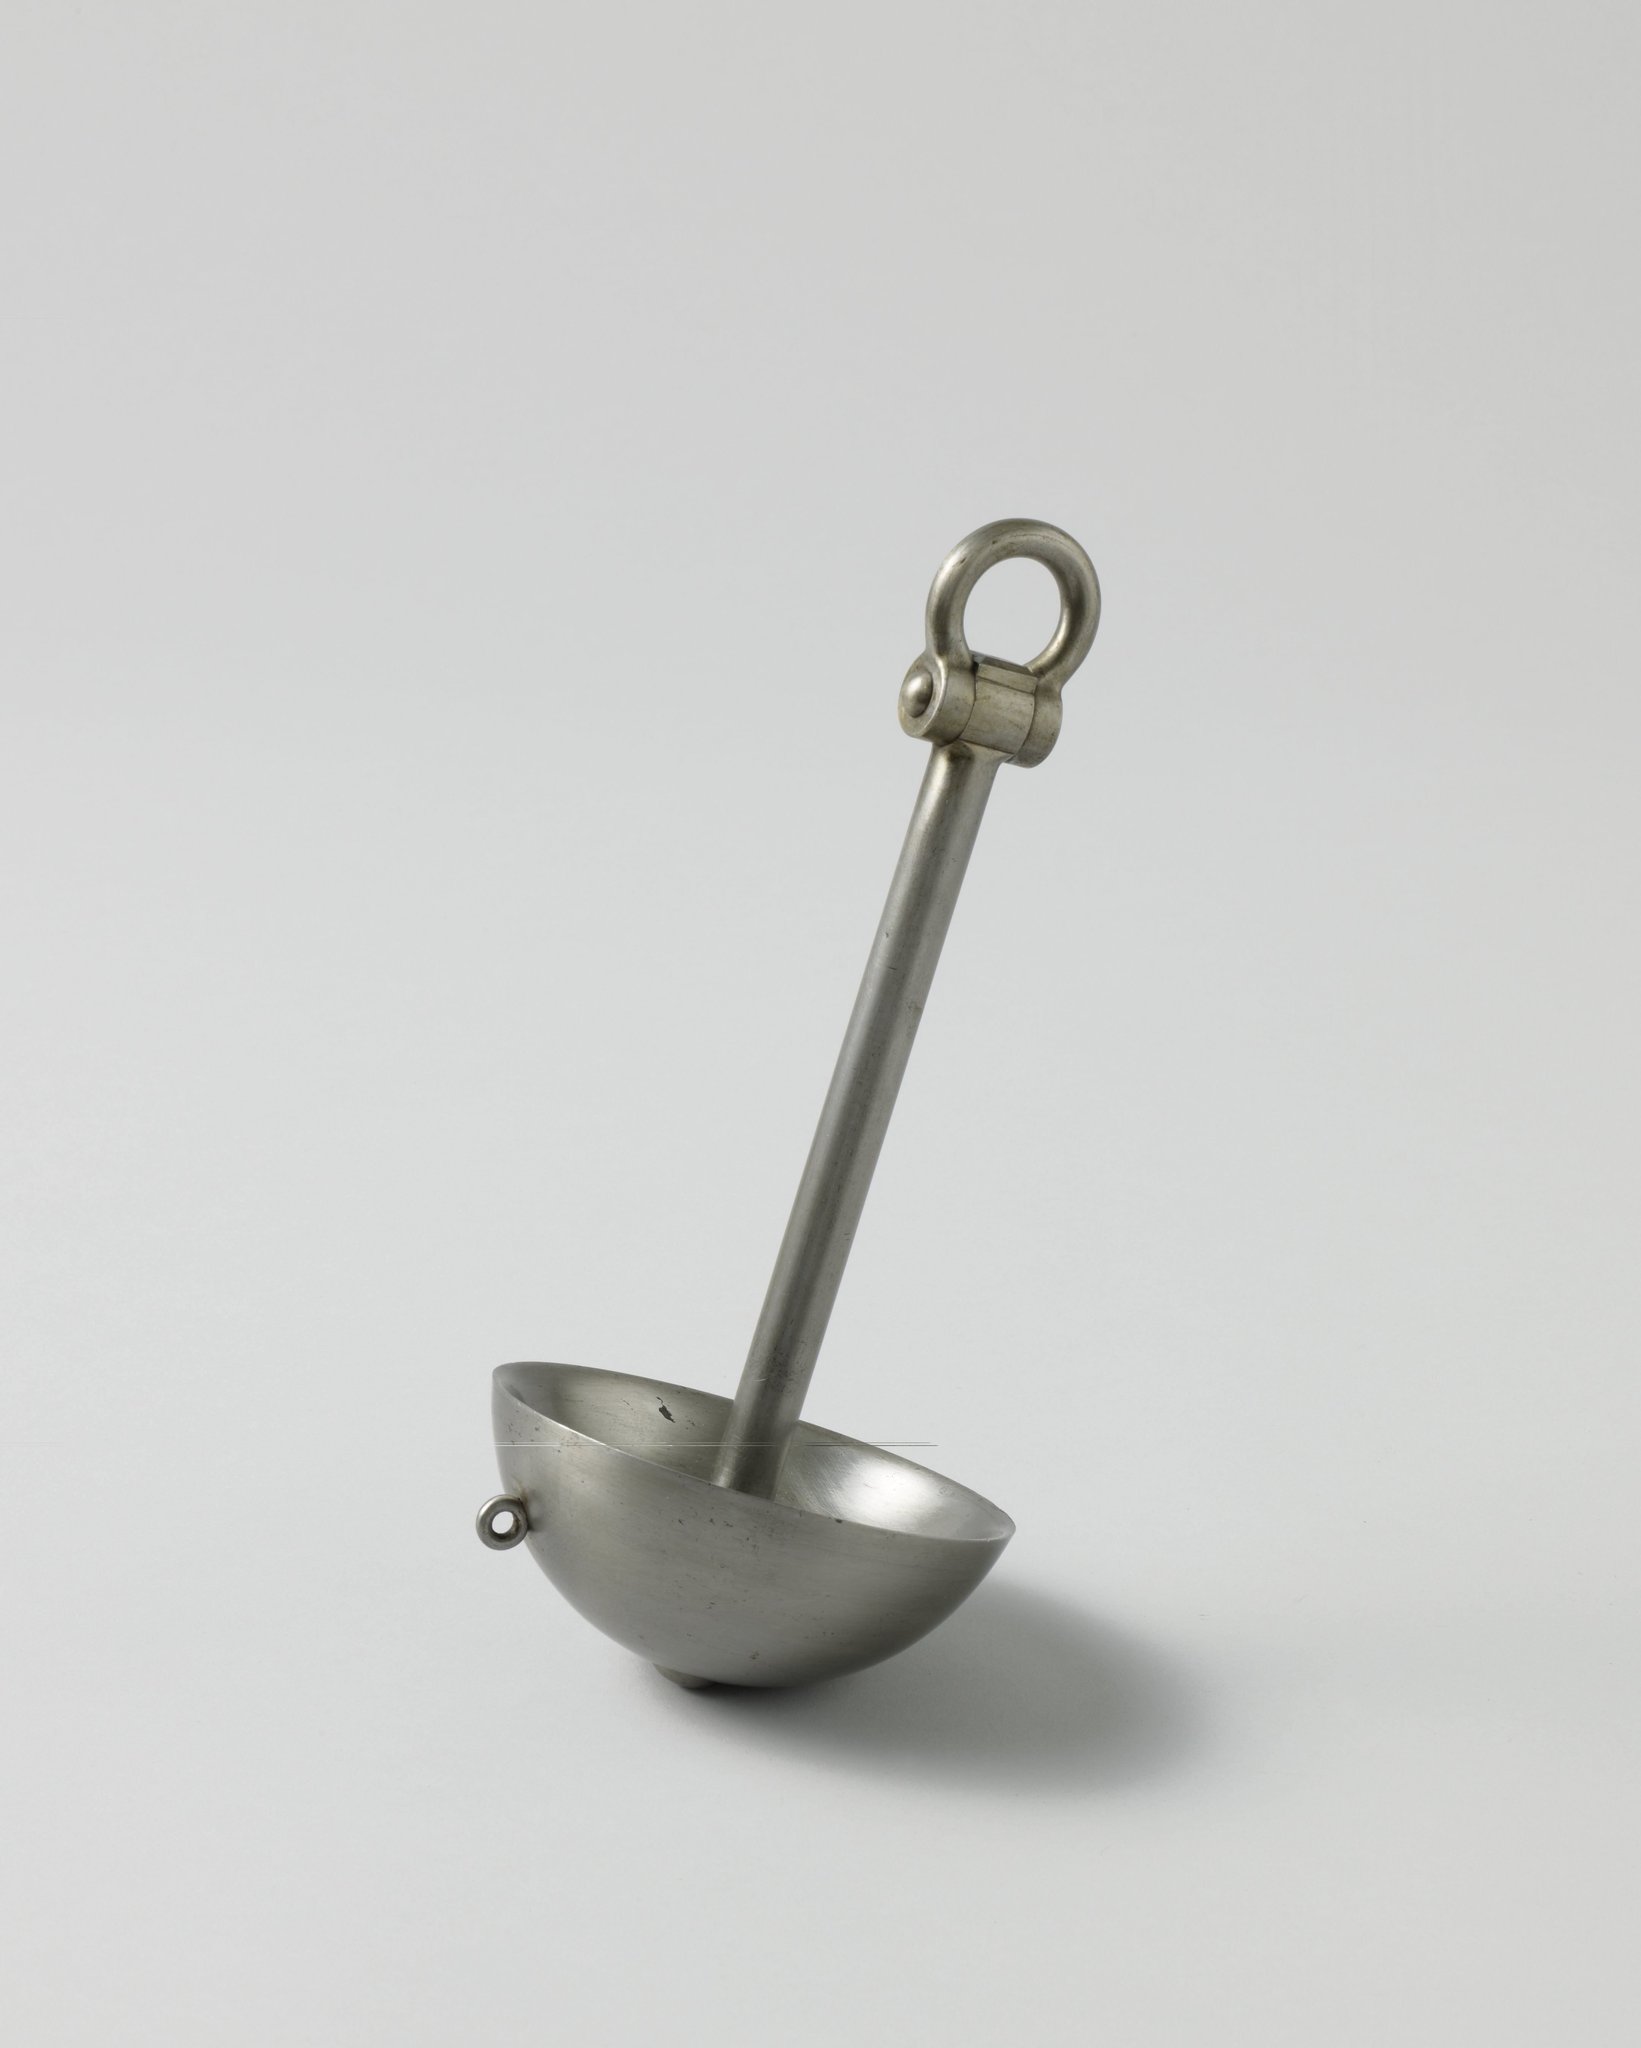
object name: demonstration model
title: Model of an Anchor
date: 1860-1863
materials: iron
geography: leiden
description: Model van een paddestoel-anker. Het bestaat uit een schacht met een harp aan het einde, terwijl de armen vervangen zijn door de sectie van een bol, naar het midden verzwaard. Hieraan is nog een oog bevestigd. Schaal 1:10 (schatting).